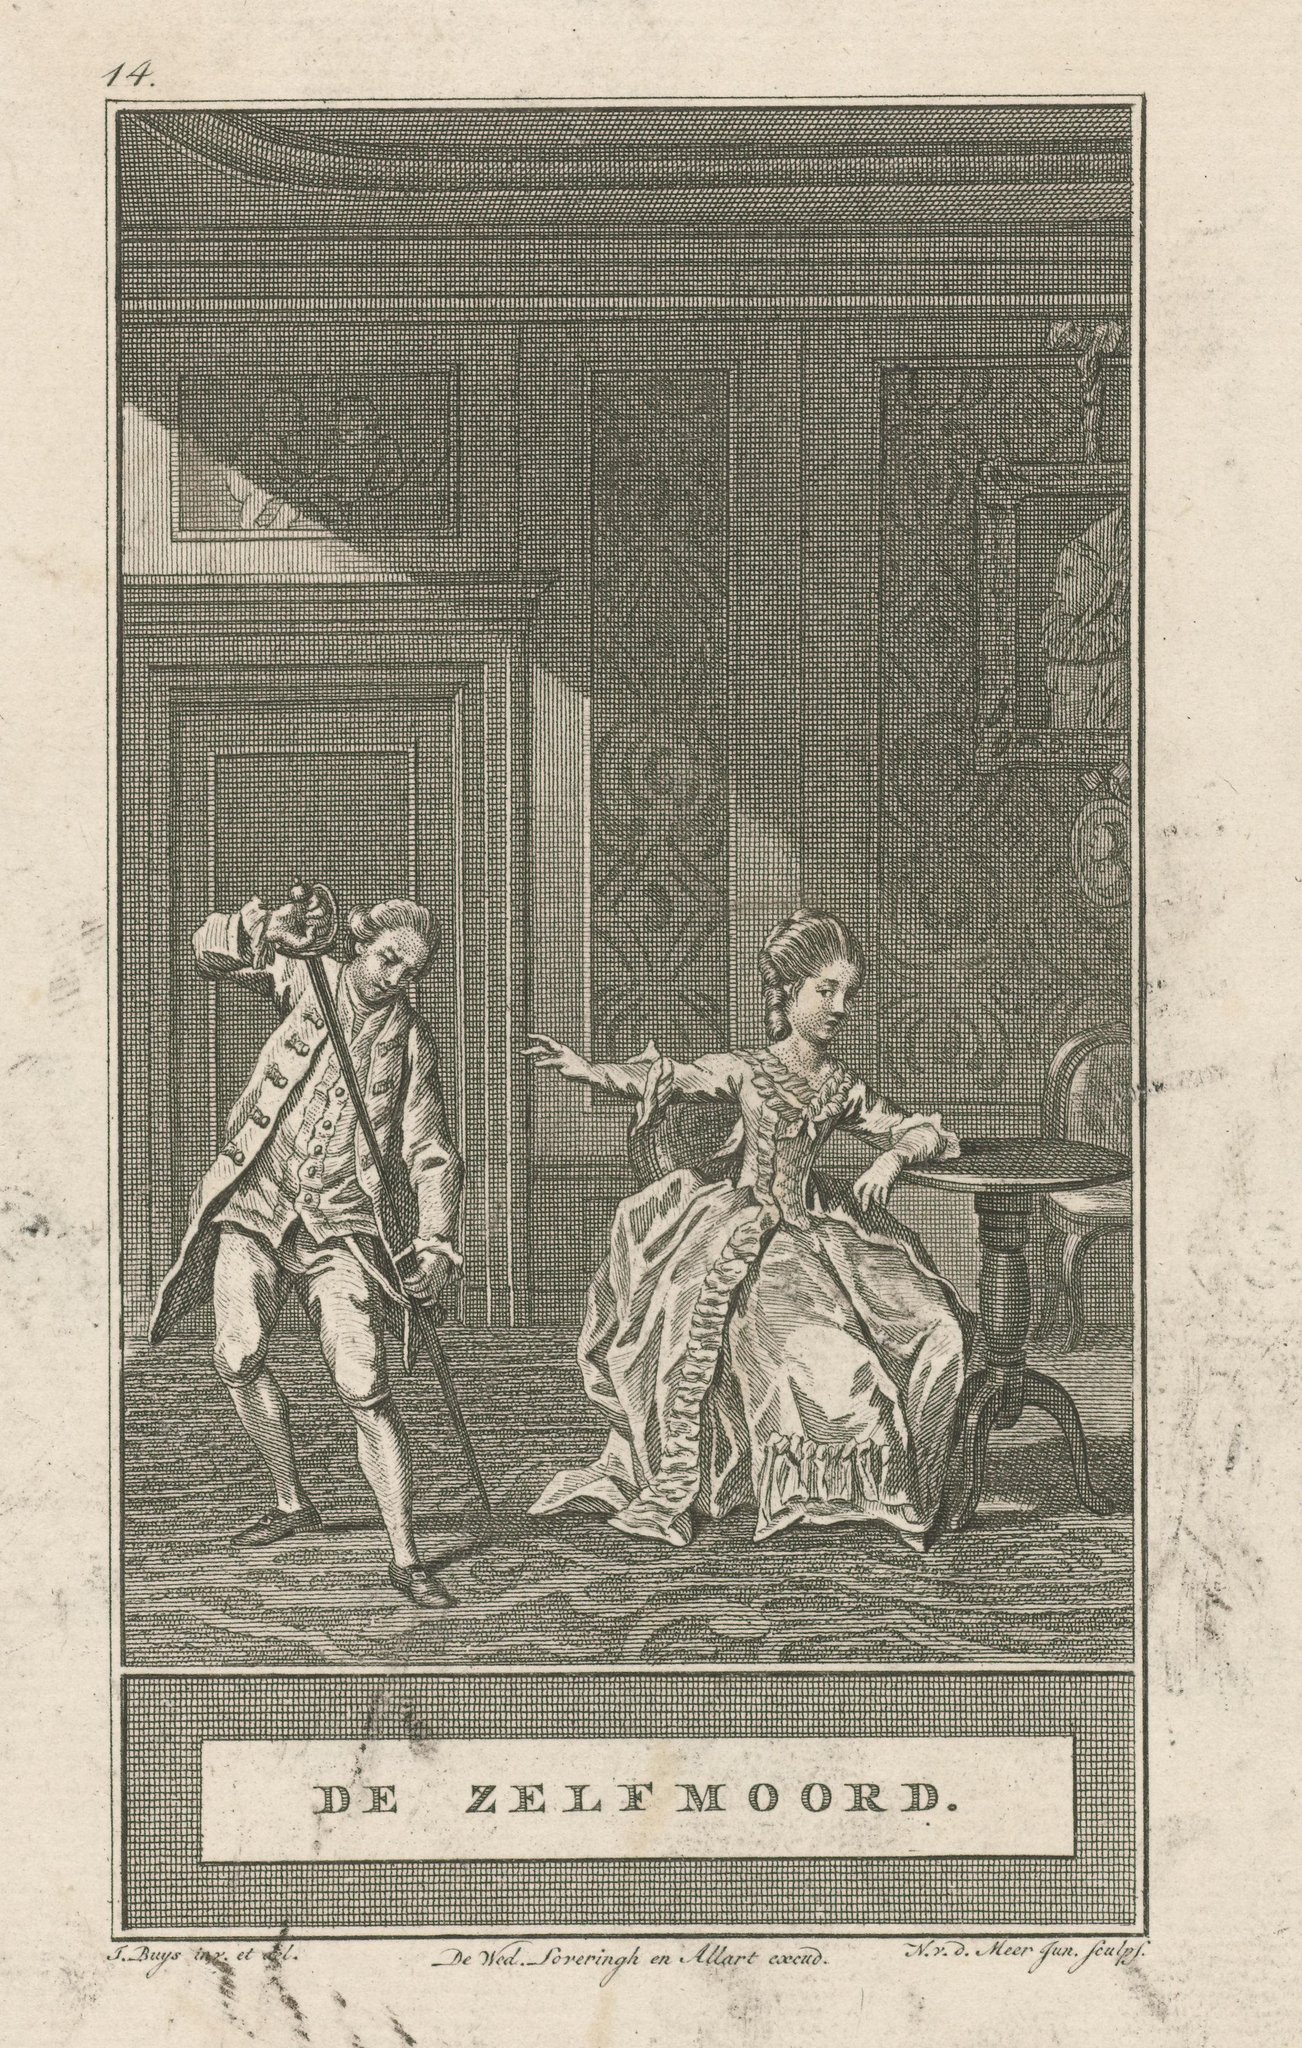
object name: book illustration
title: Man trekt zijn zwaard om zelfmoord te plegen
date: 1777-1778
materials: paper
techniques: etching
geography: amsterdam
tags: being refused, the proposal rejected, suicide out of despair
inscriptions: collector's mark: Lugt 2228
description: Prent bij: Gellert, Christian Fürchtegott. Fabelen en vertelsels. 3 dln. Amsterdam: Pieter Meyer, 1772-1774. De prenten bij deze publicatie werden later uitgegeven. De exemplaren uitgegeven door de weduwe Jacobus Loveringh & Johannes Allart tussen 1777 en 1778, de exemplaren uitgegeven door alleen Johannes Allart tussen 1778 en 1785.